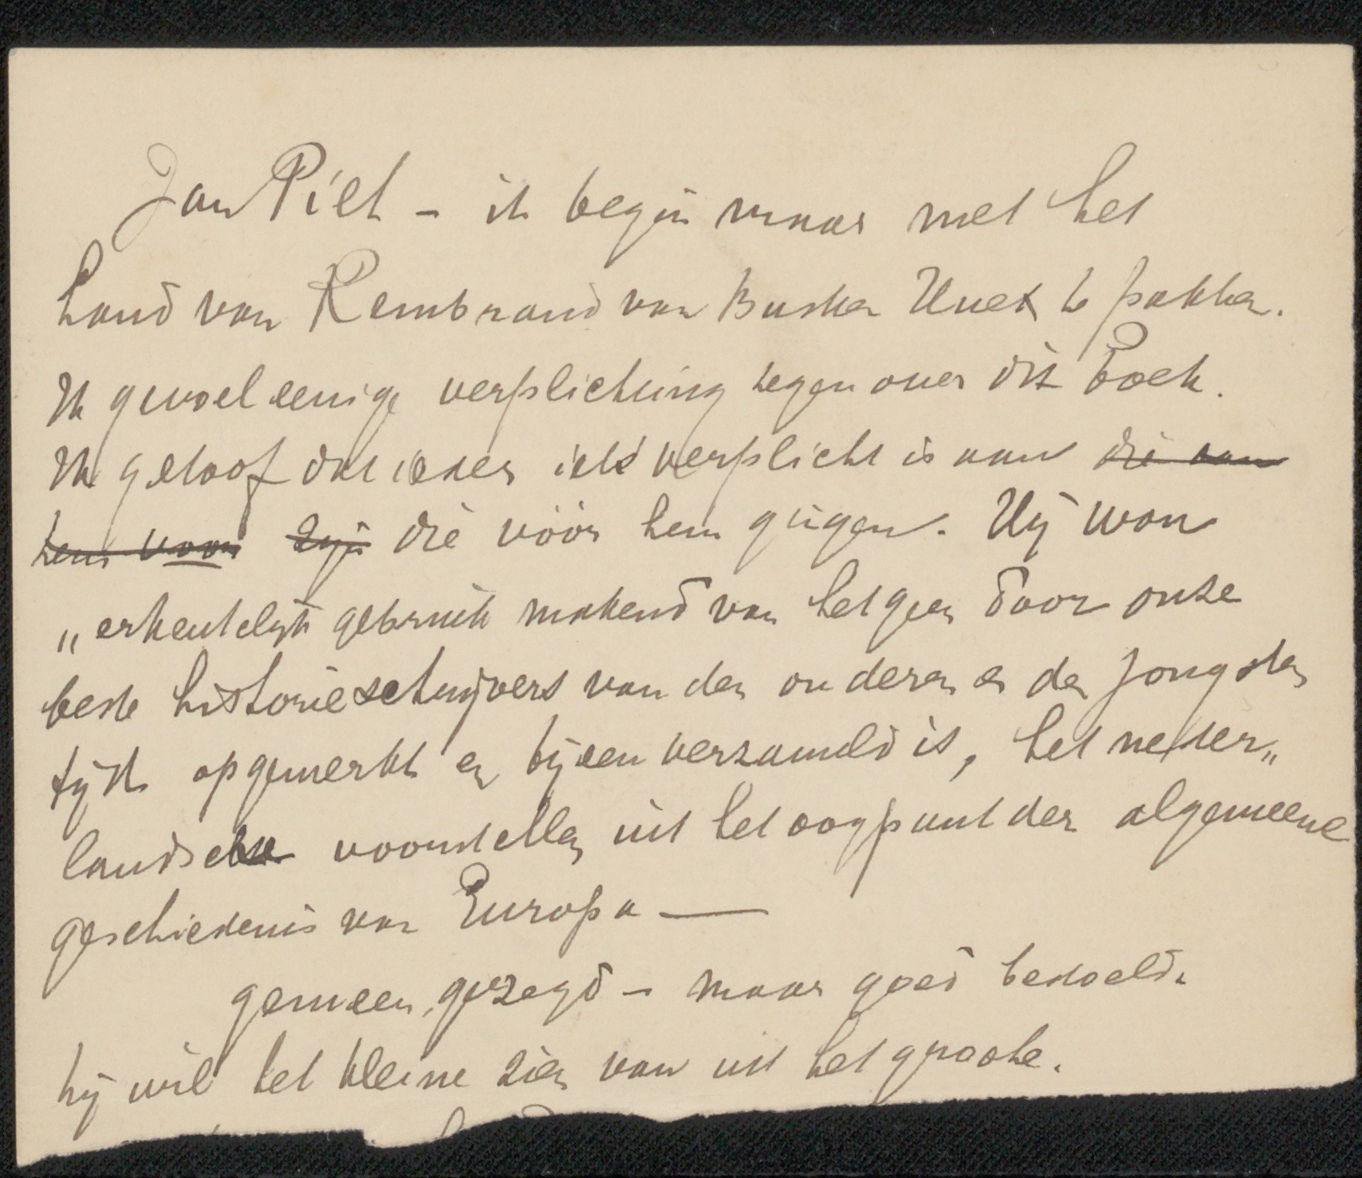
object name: letter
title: Brief aan Jan Veth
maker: antoon derkinderen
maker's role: draughtsman, painter, print maker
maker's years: 1859-1925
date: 1874-1925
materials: ink, paper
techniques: pen, writing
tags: designer, jan veth, paris, literature ~ arts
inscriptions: collector's mark: ‘RPK’